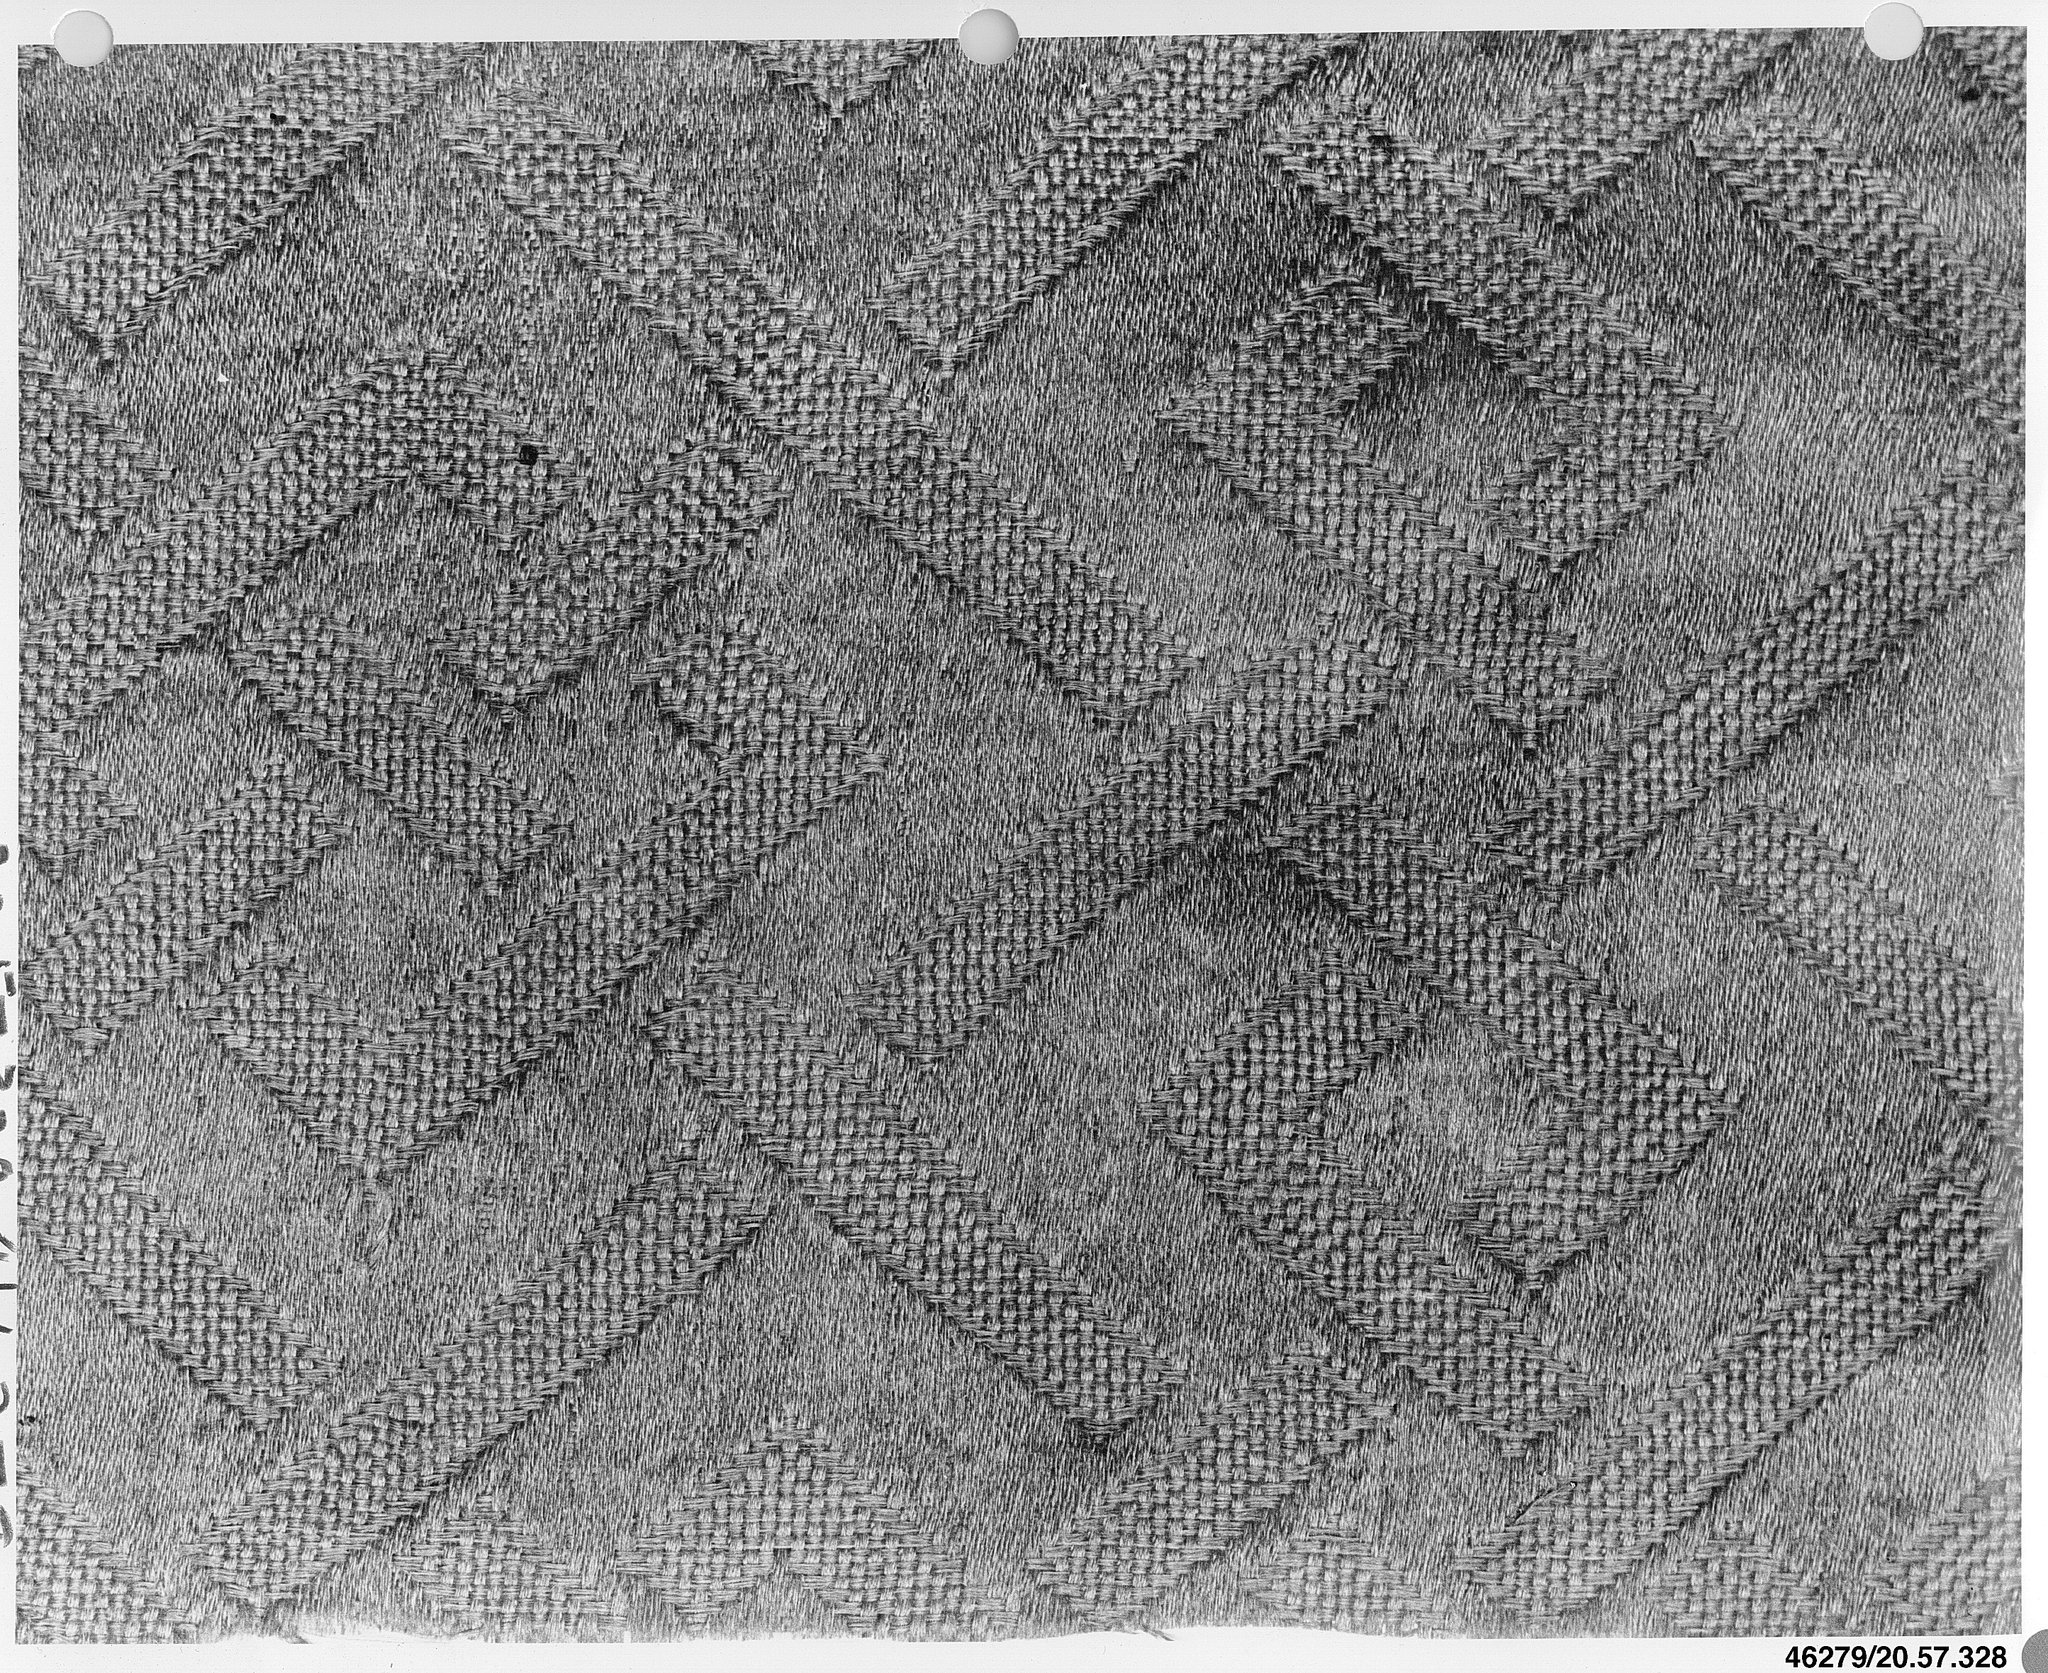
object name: piece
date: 1701-1800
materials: silk